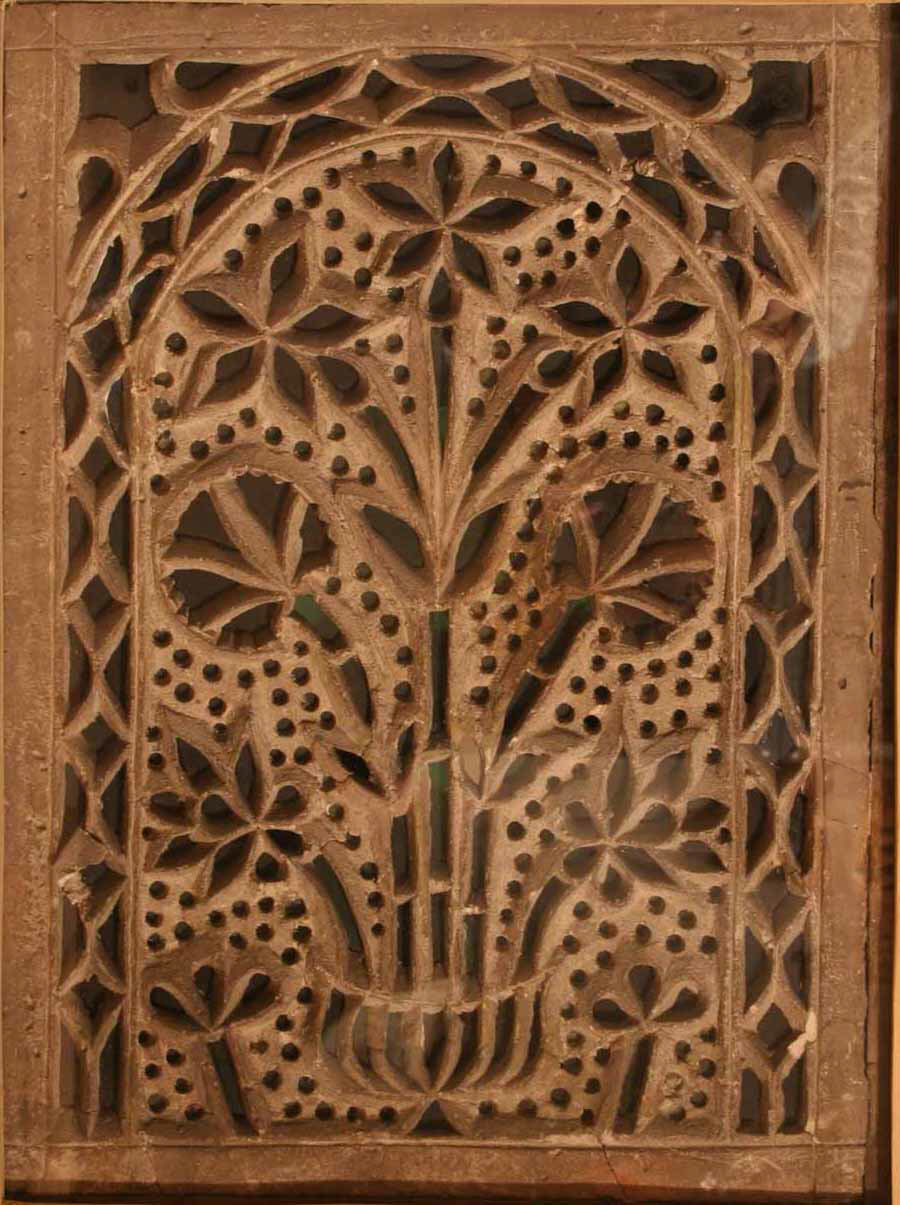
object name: window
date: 1701-1800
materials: gypsum, glass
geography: egypt or syria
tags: flowers